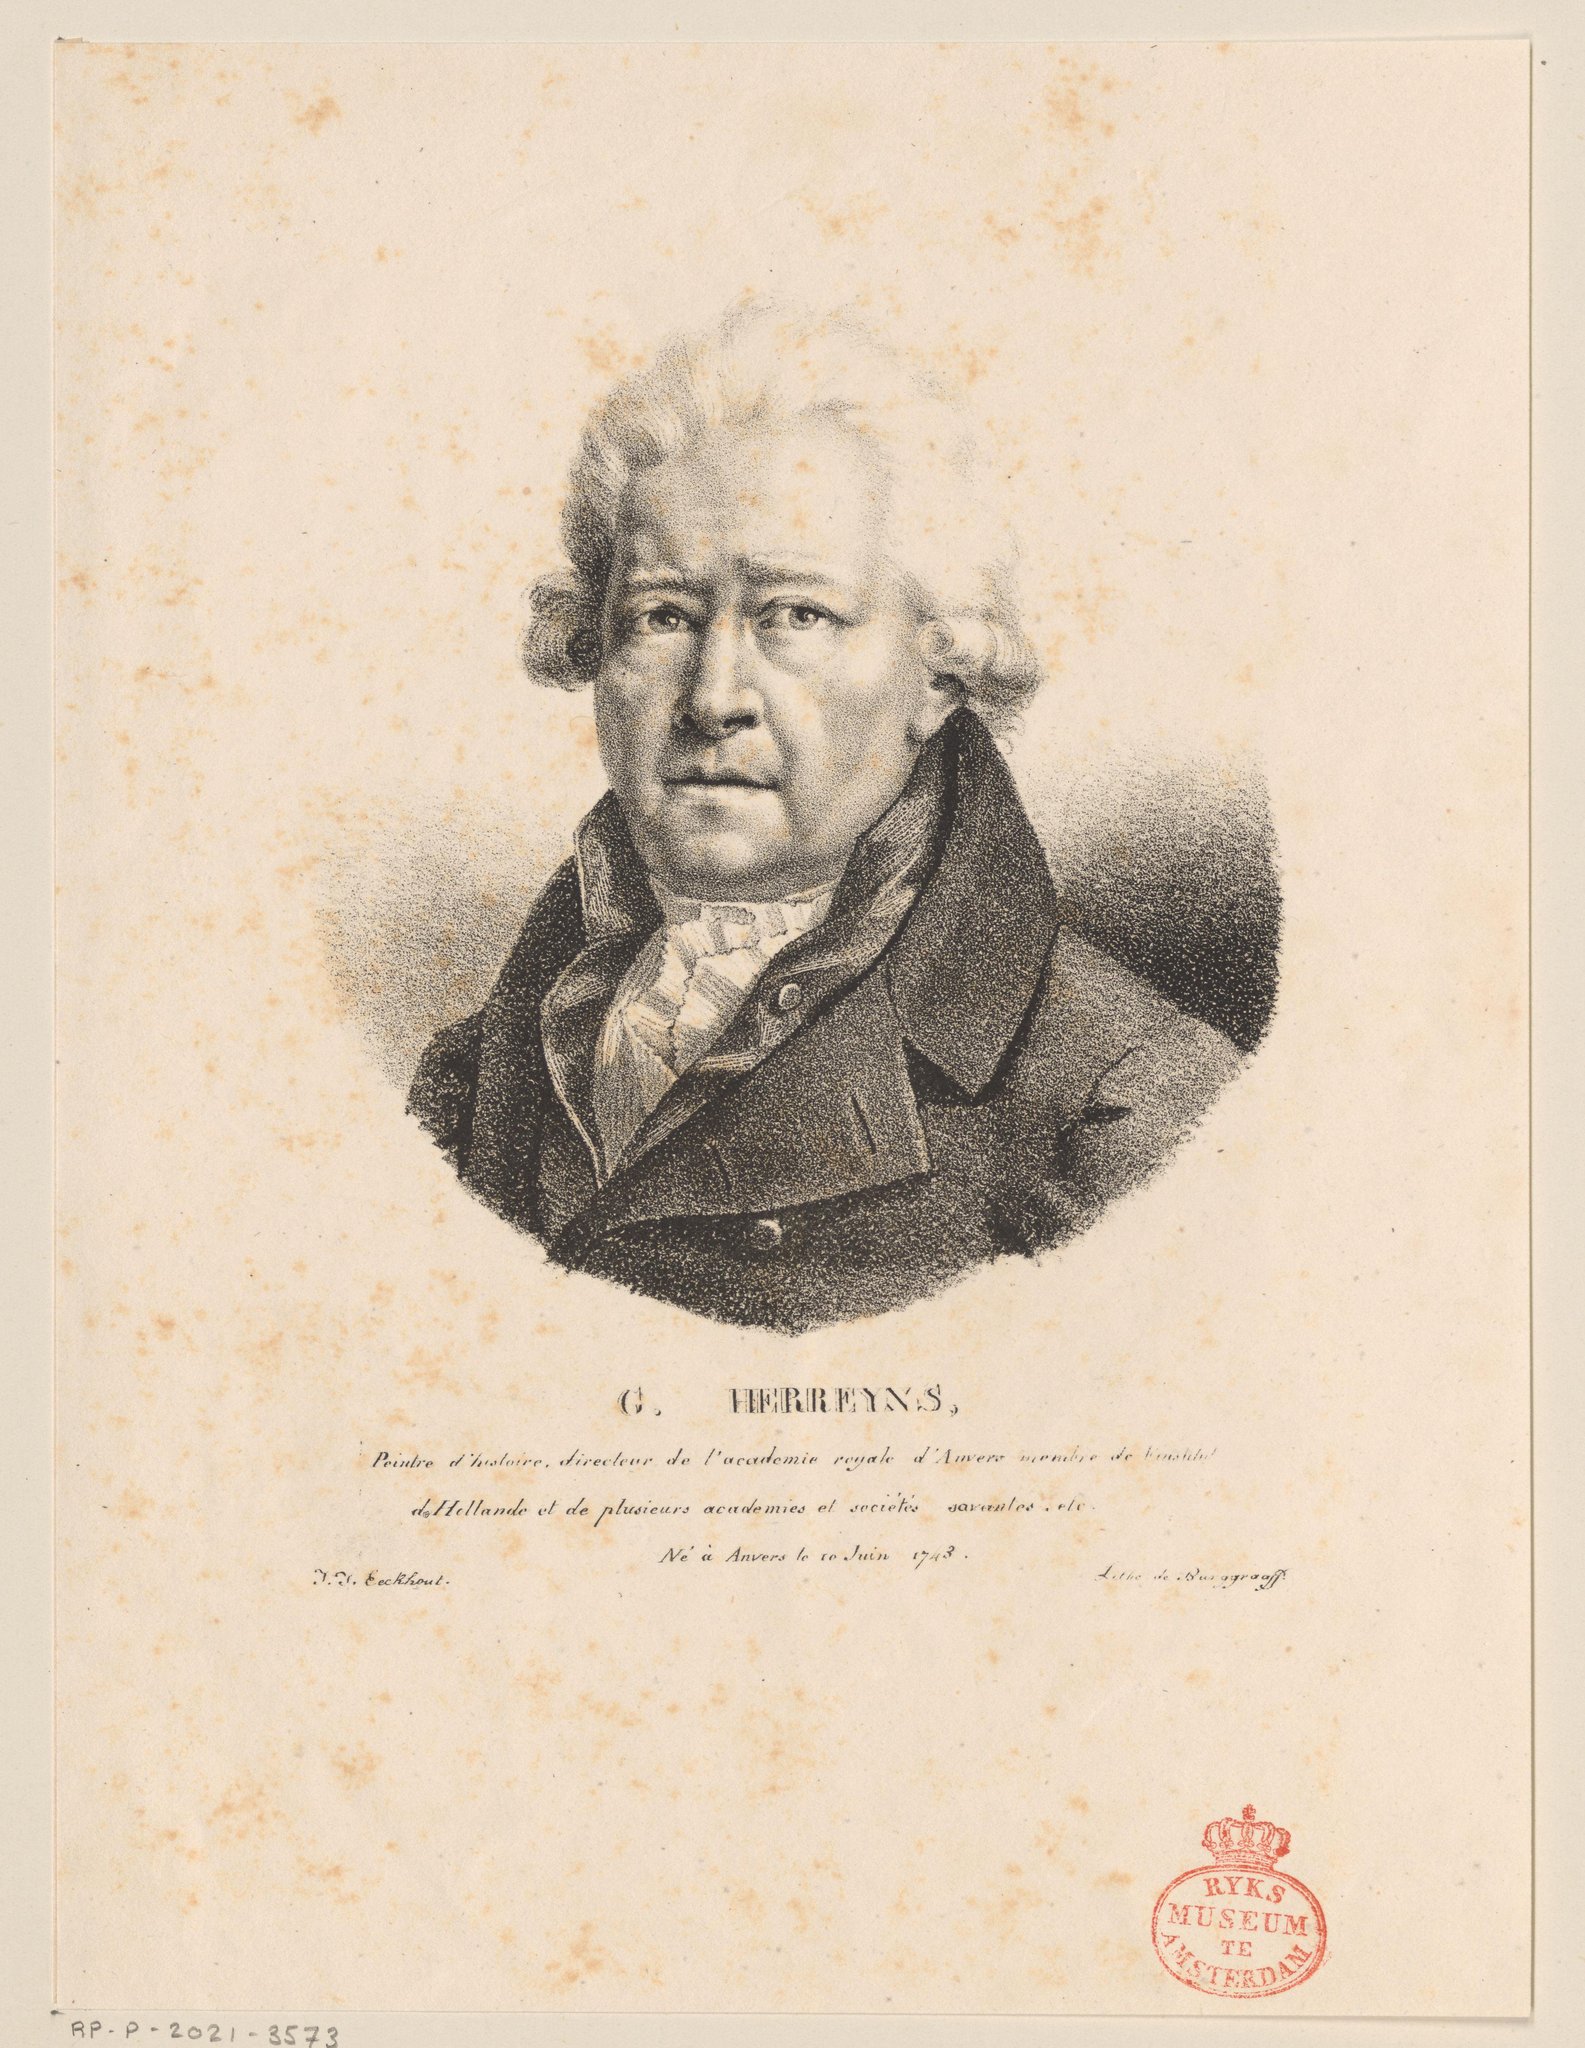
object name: print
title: Portret van Willem Jacob Herreyns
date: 1820-1853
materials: paper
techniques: lithograph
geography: brussels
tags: antwerp, draughtsman, willem jacob herreyns, historical persons, portrait, self-portrait of painter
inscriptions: collector's mark: Lugt 12